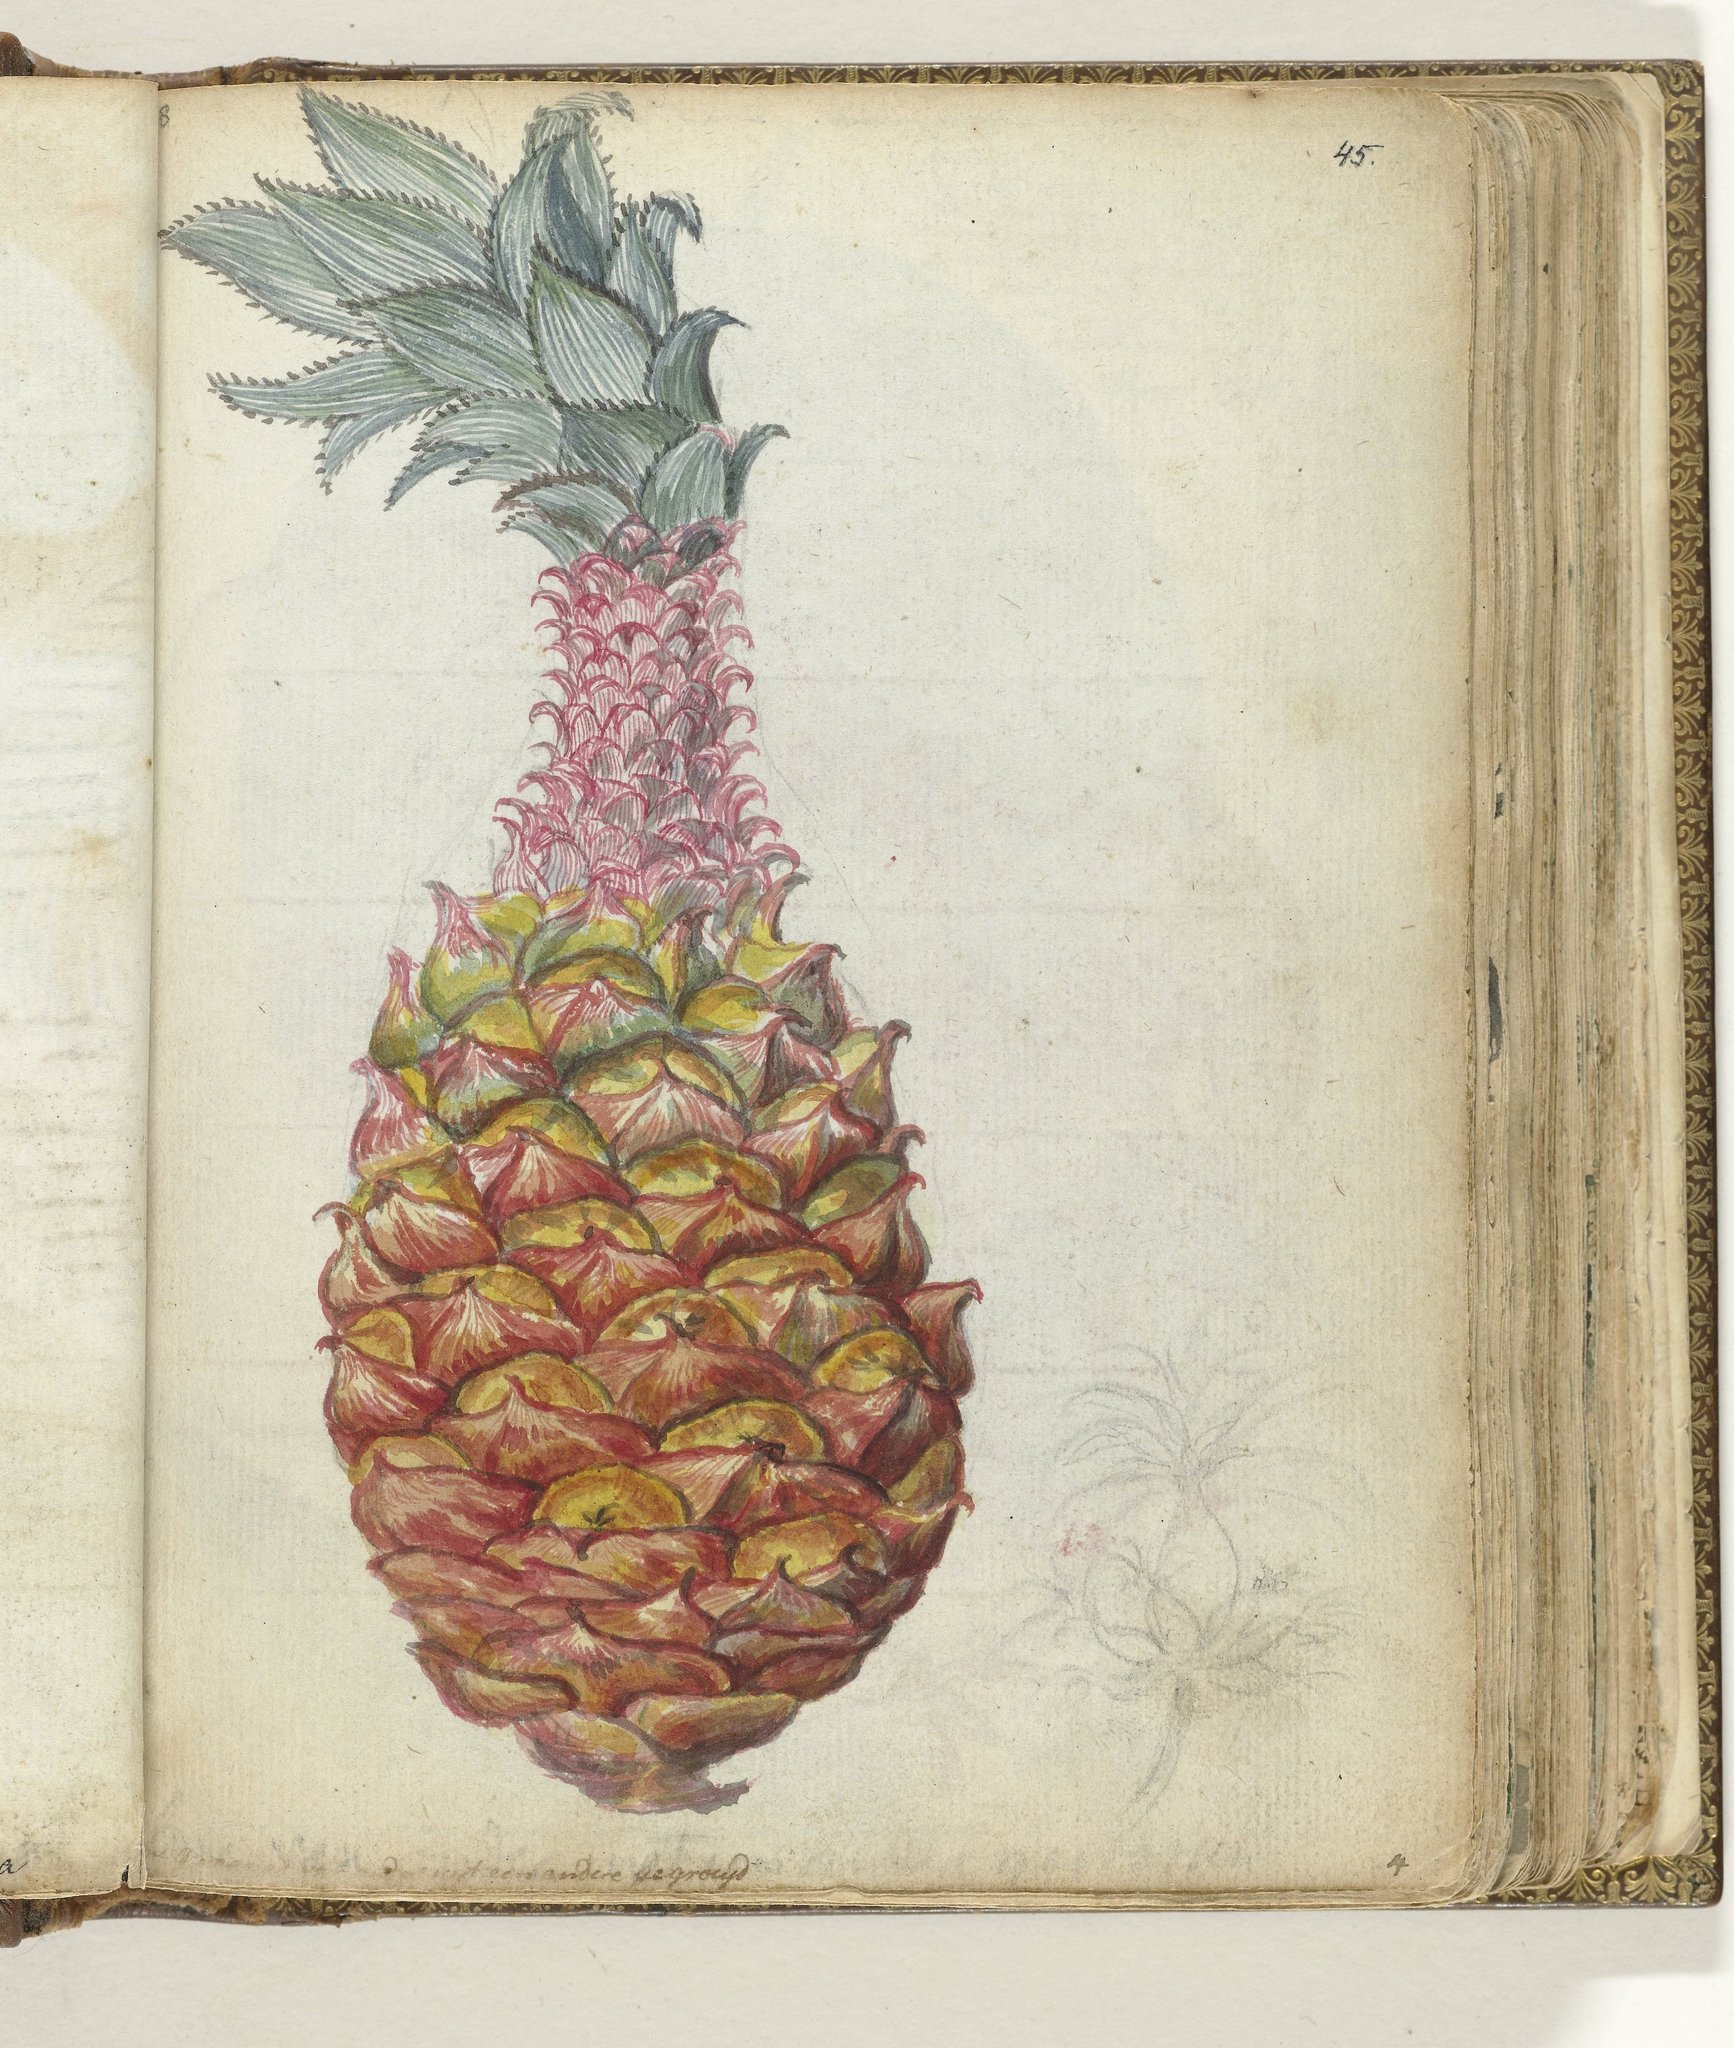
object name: drawing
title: Ananas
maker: jan brandes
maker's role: draughtsman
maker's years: 1743-1808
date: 1701-1785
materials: paper, pencil, watercolor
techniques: brush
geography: sri lanka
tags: fruits: pineapple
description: Kleurtekening van een uitgelopen ananas. Met opschrift. Onderdeel uit het schetsboek van Jan Brandes, dl. 1 (1808), p. 45.